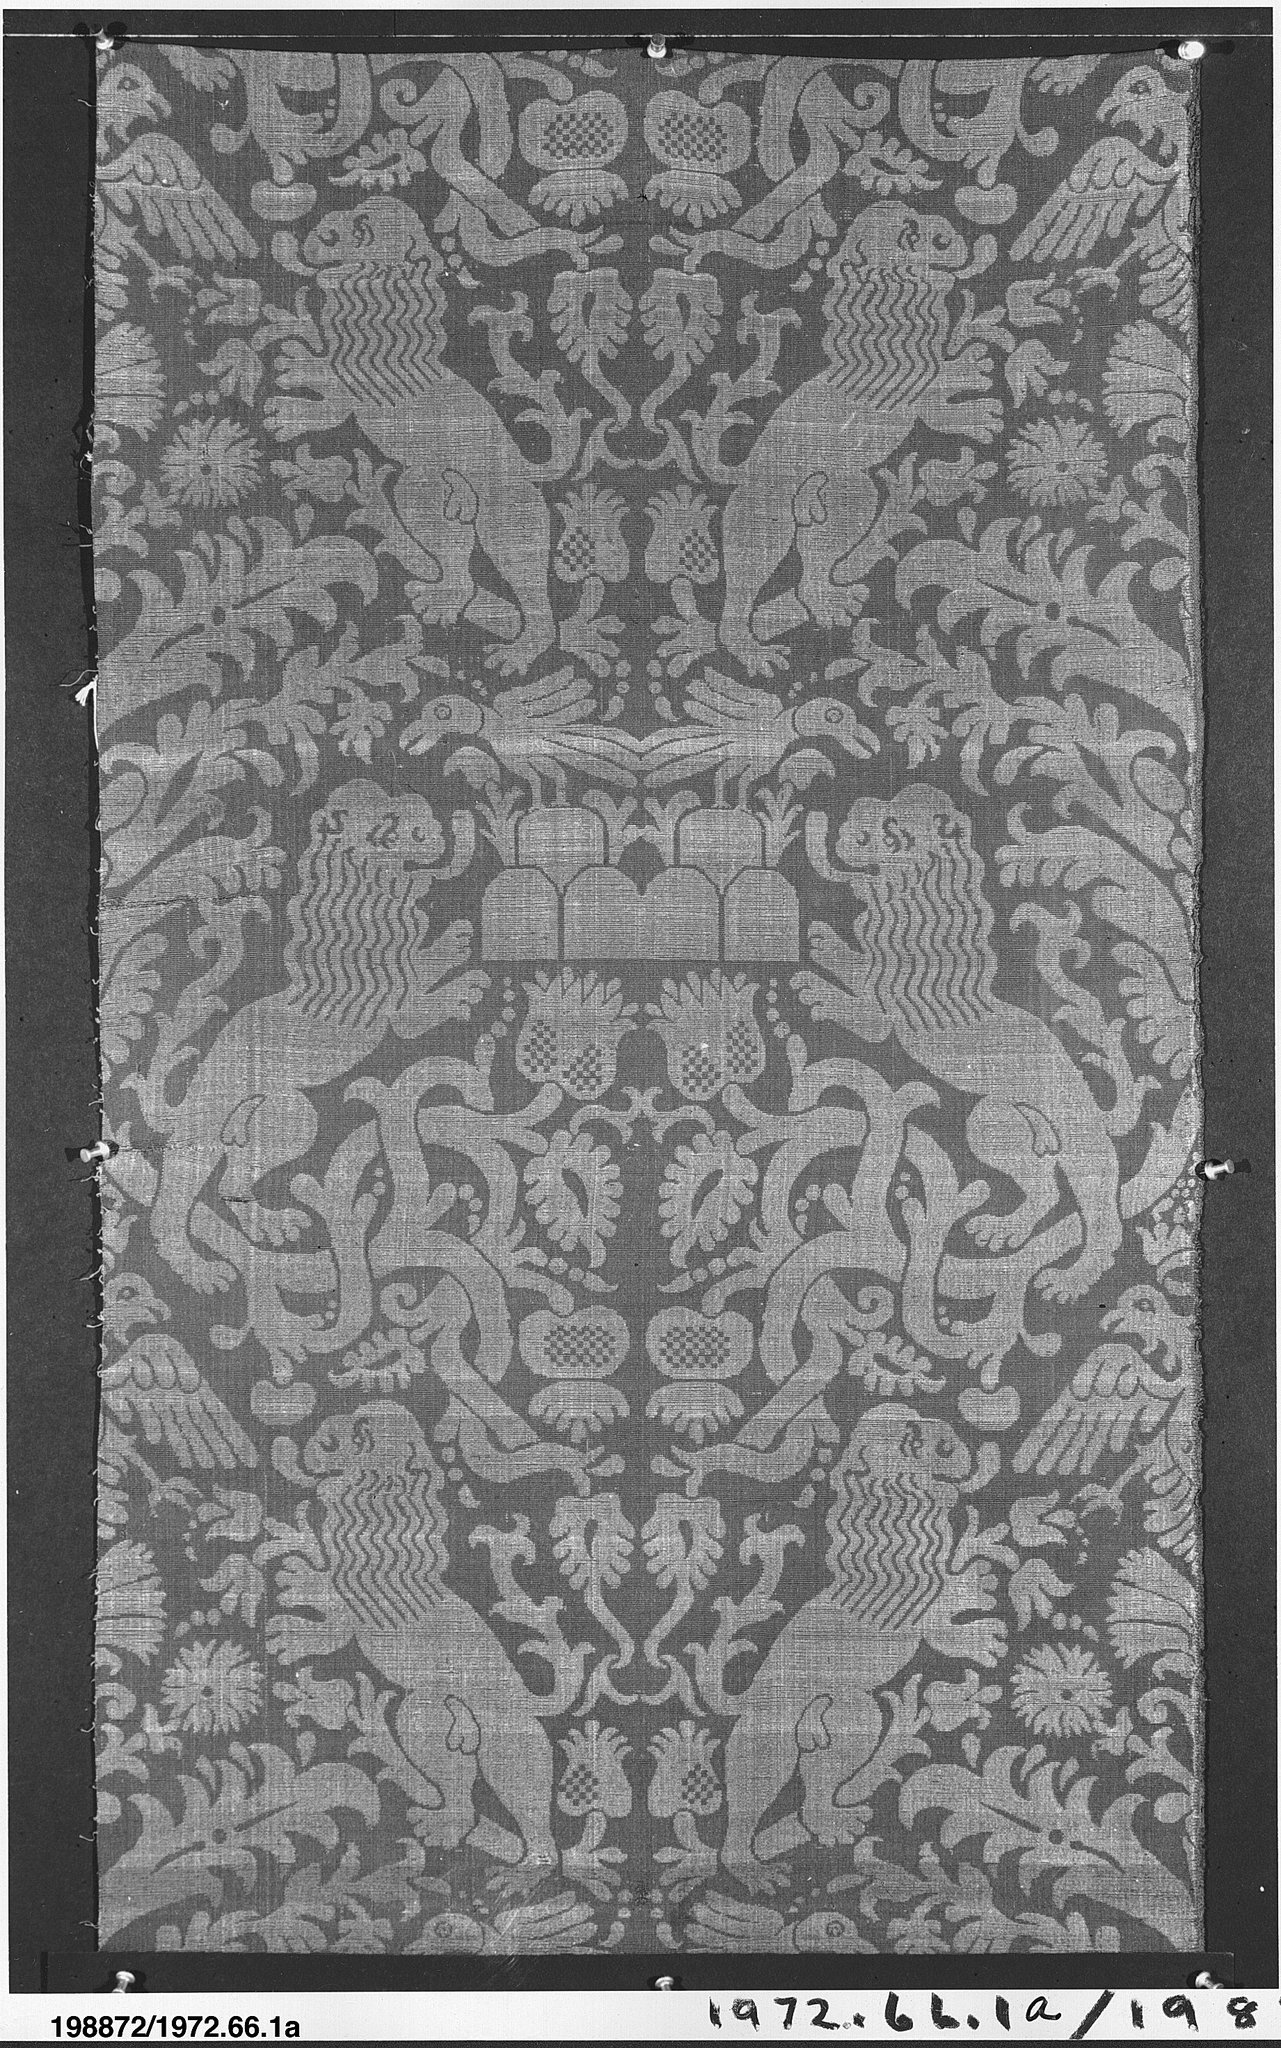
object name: piece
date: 1501-1600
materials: silk, silver gilt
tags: birds,lions,flowers,leaves